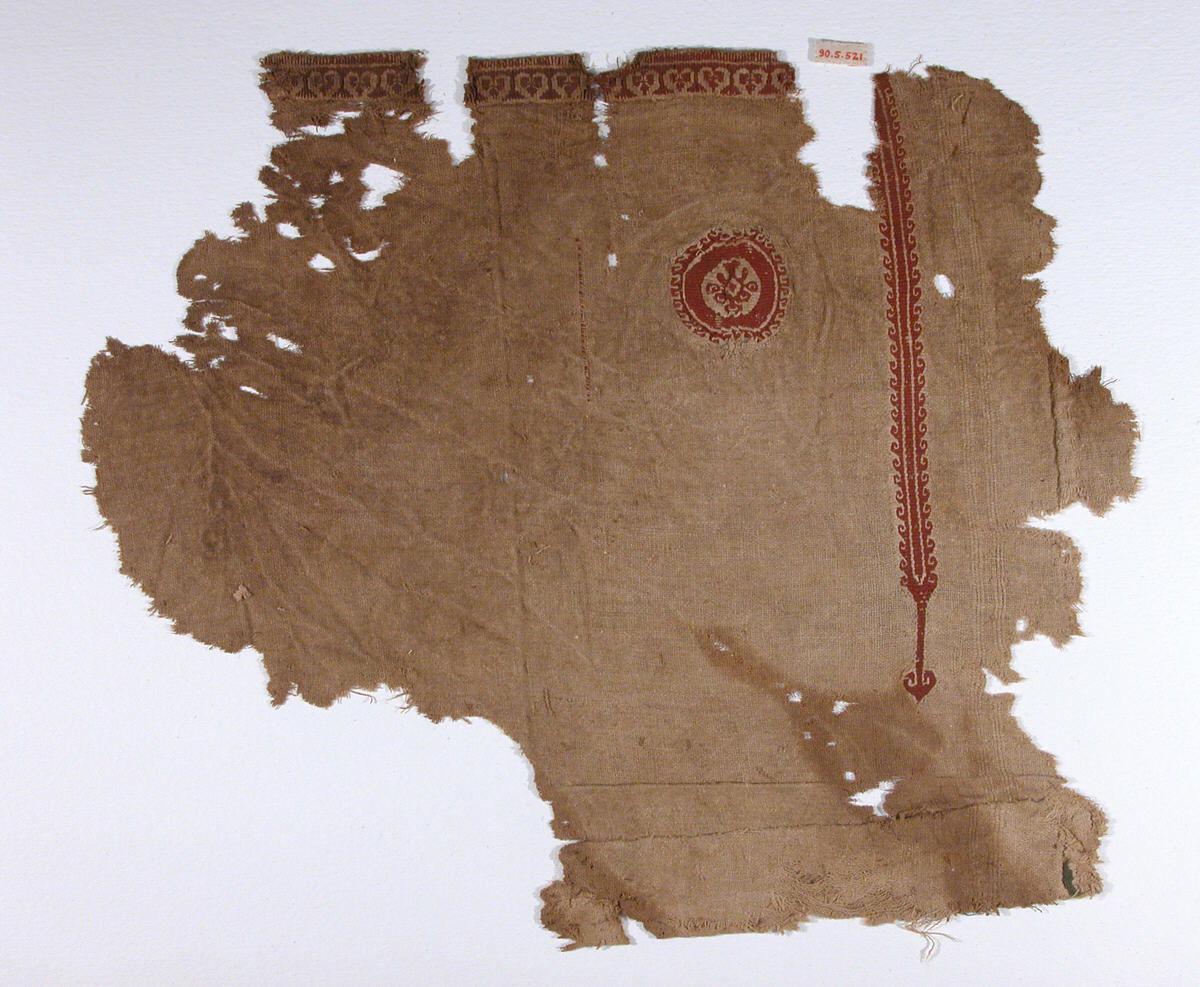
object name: textile fragment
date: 201-400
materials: linen, wool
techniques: weave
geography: egypt